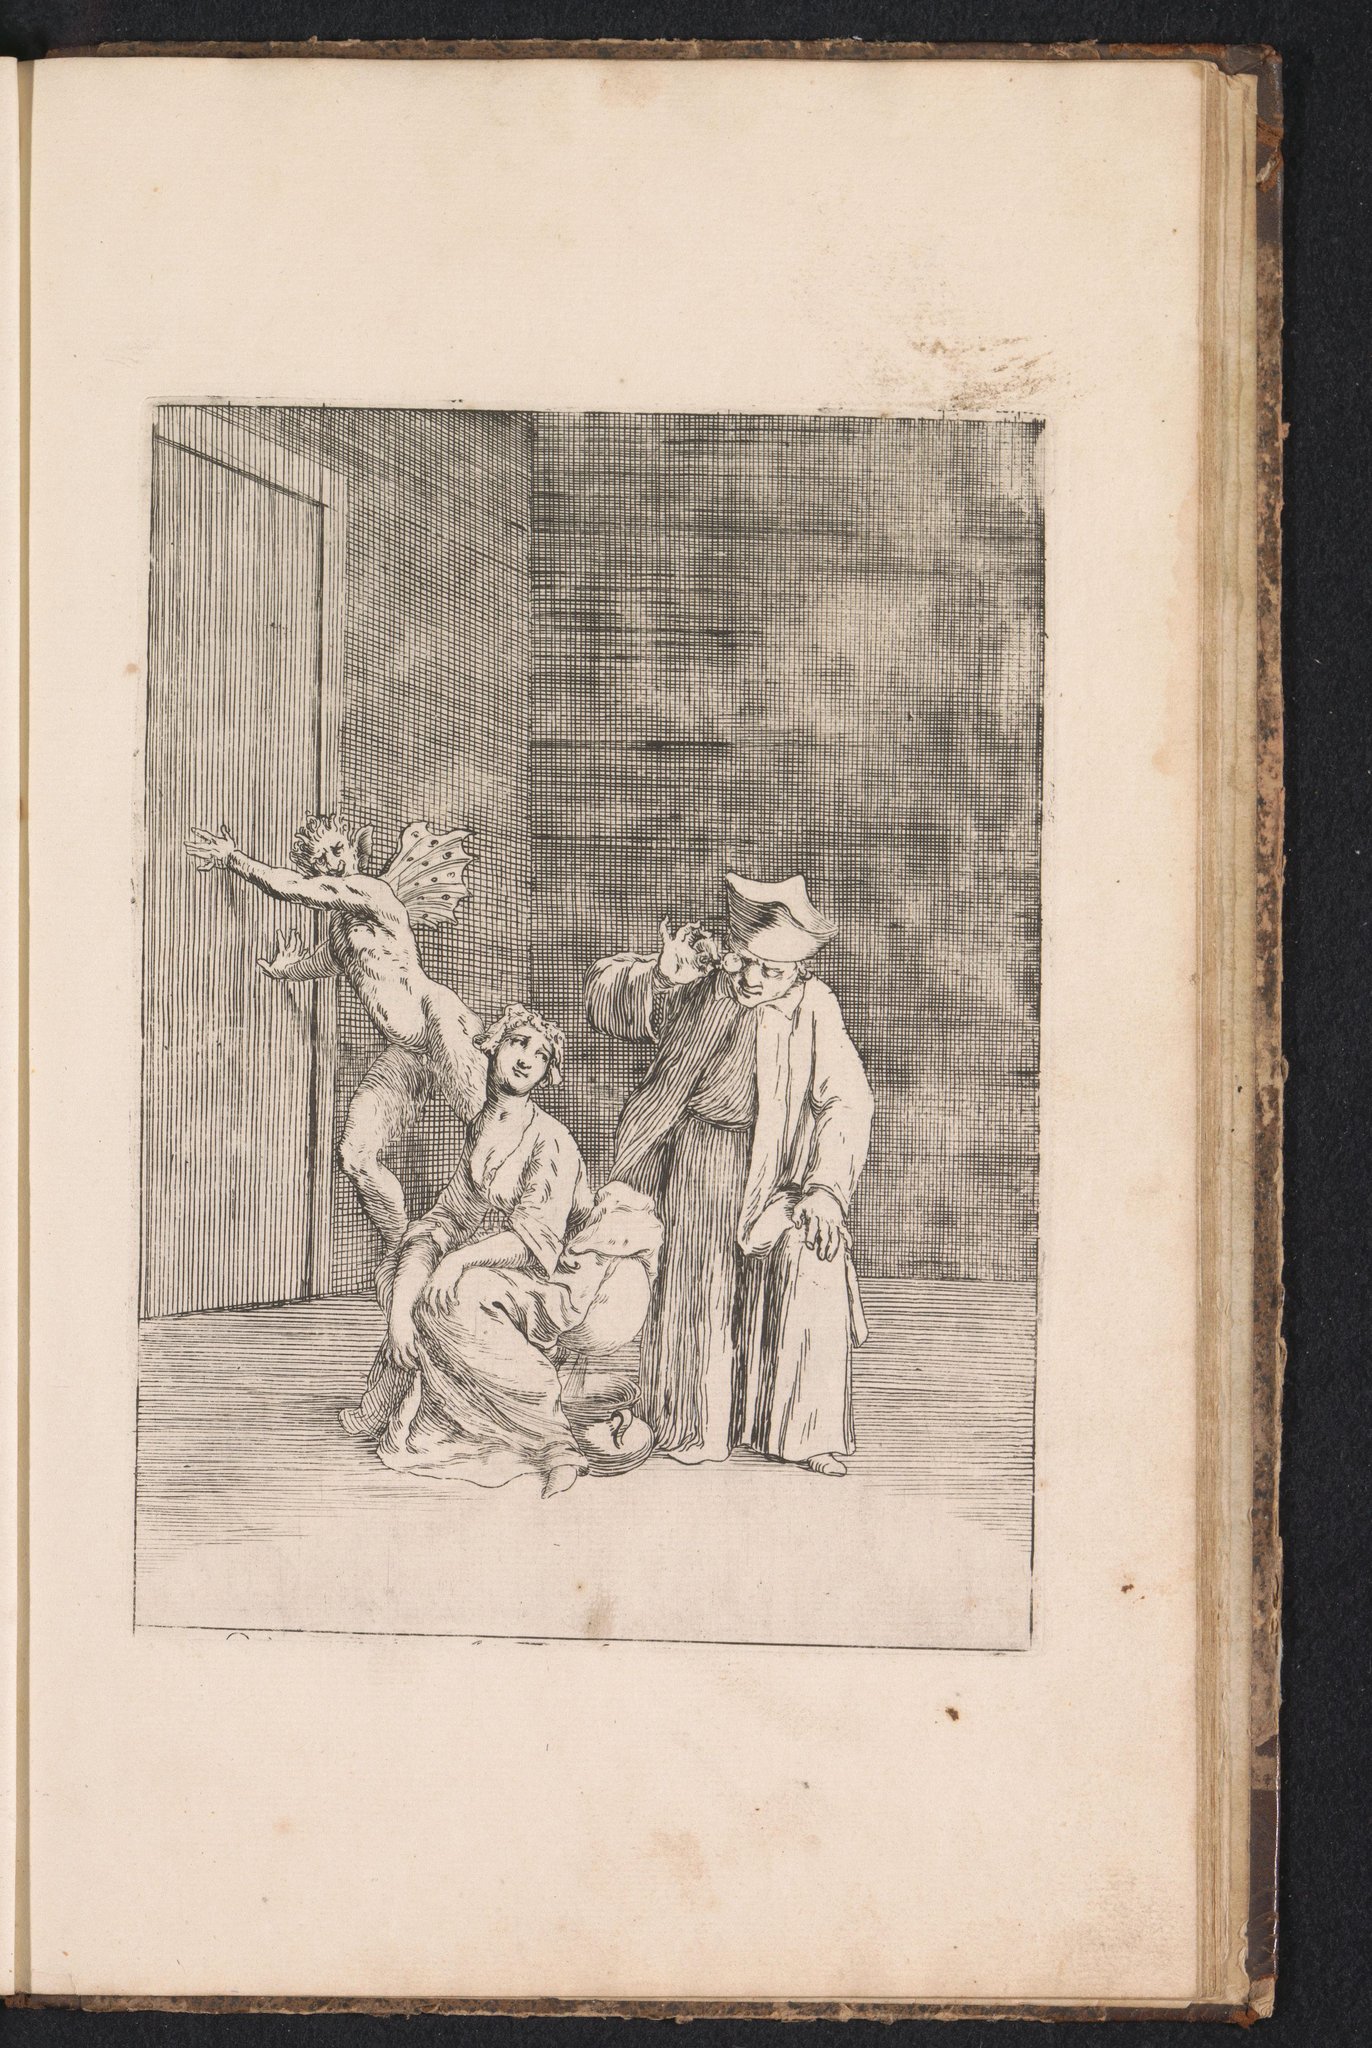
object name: print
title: Historische print- en dicht-taferelen van Jan Baptist Girard, en jufrou Maria Catherina Cadiere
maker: jacques gabriel huquier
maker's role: draughtsman, painter, print maker, publisher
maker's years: 1725-1805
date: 1735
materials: paper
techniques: etching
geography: france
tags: witch, sorcerer with the devil and/or demons, sexual abuses of monks, miscarriage, abortion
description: Dankzij het ingenomen drankje scheidt Marie-Catherine Cadière de ongeboren vrucht uit. Onderdeel van de reeks van 32, veelal erotisch getinte, prenten gewijd aan het schandaal rond Marie-Catherine Cadière en de Jezuïet Jean-Baptiste Girard in 1730-1731.